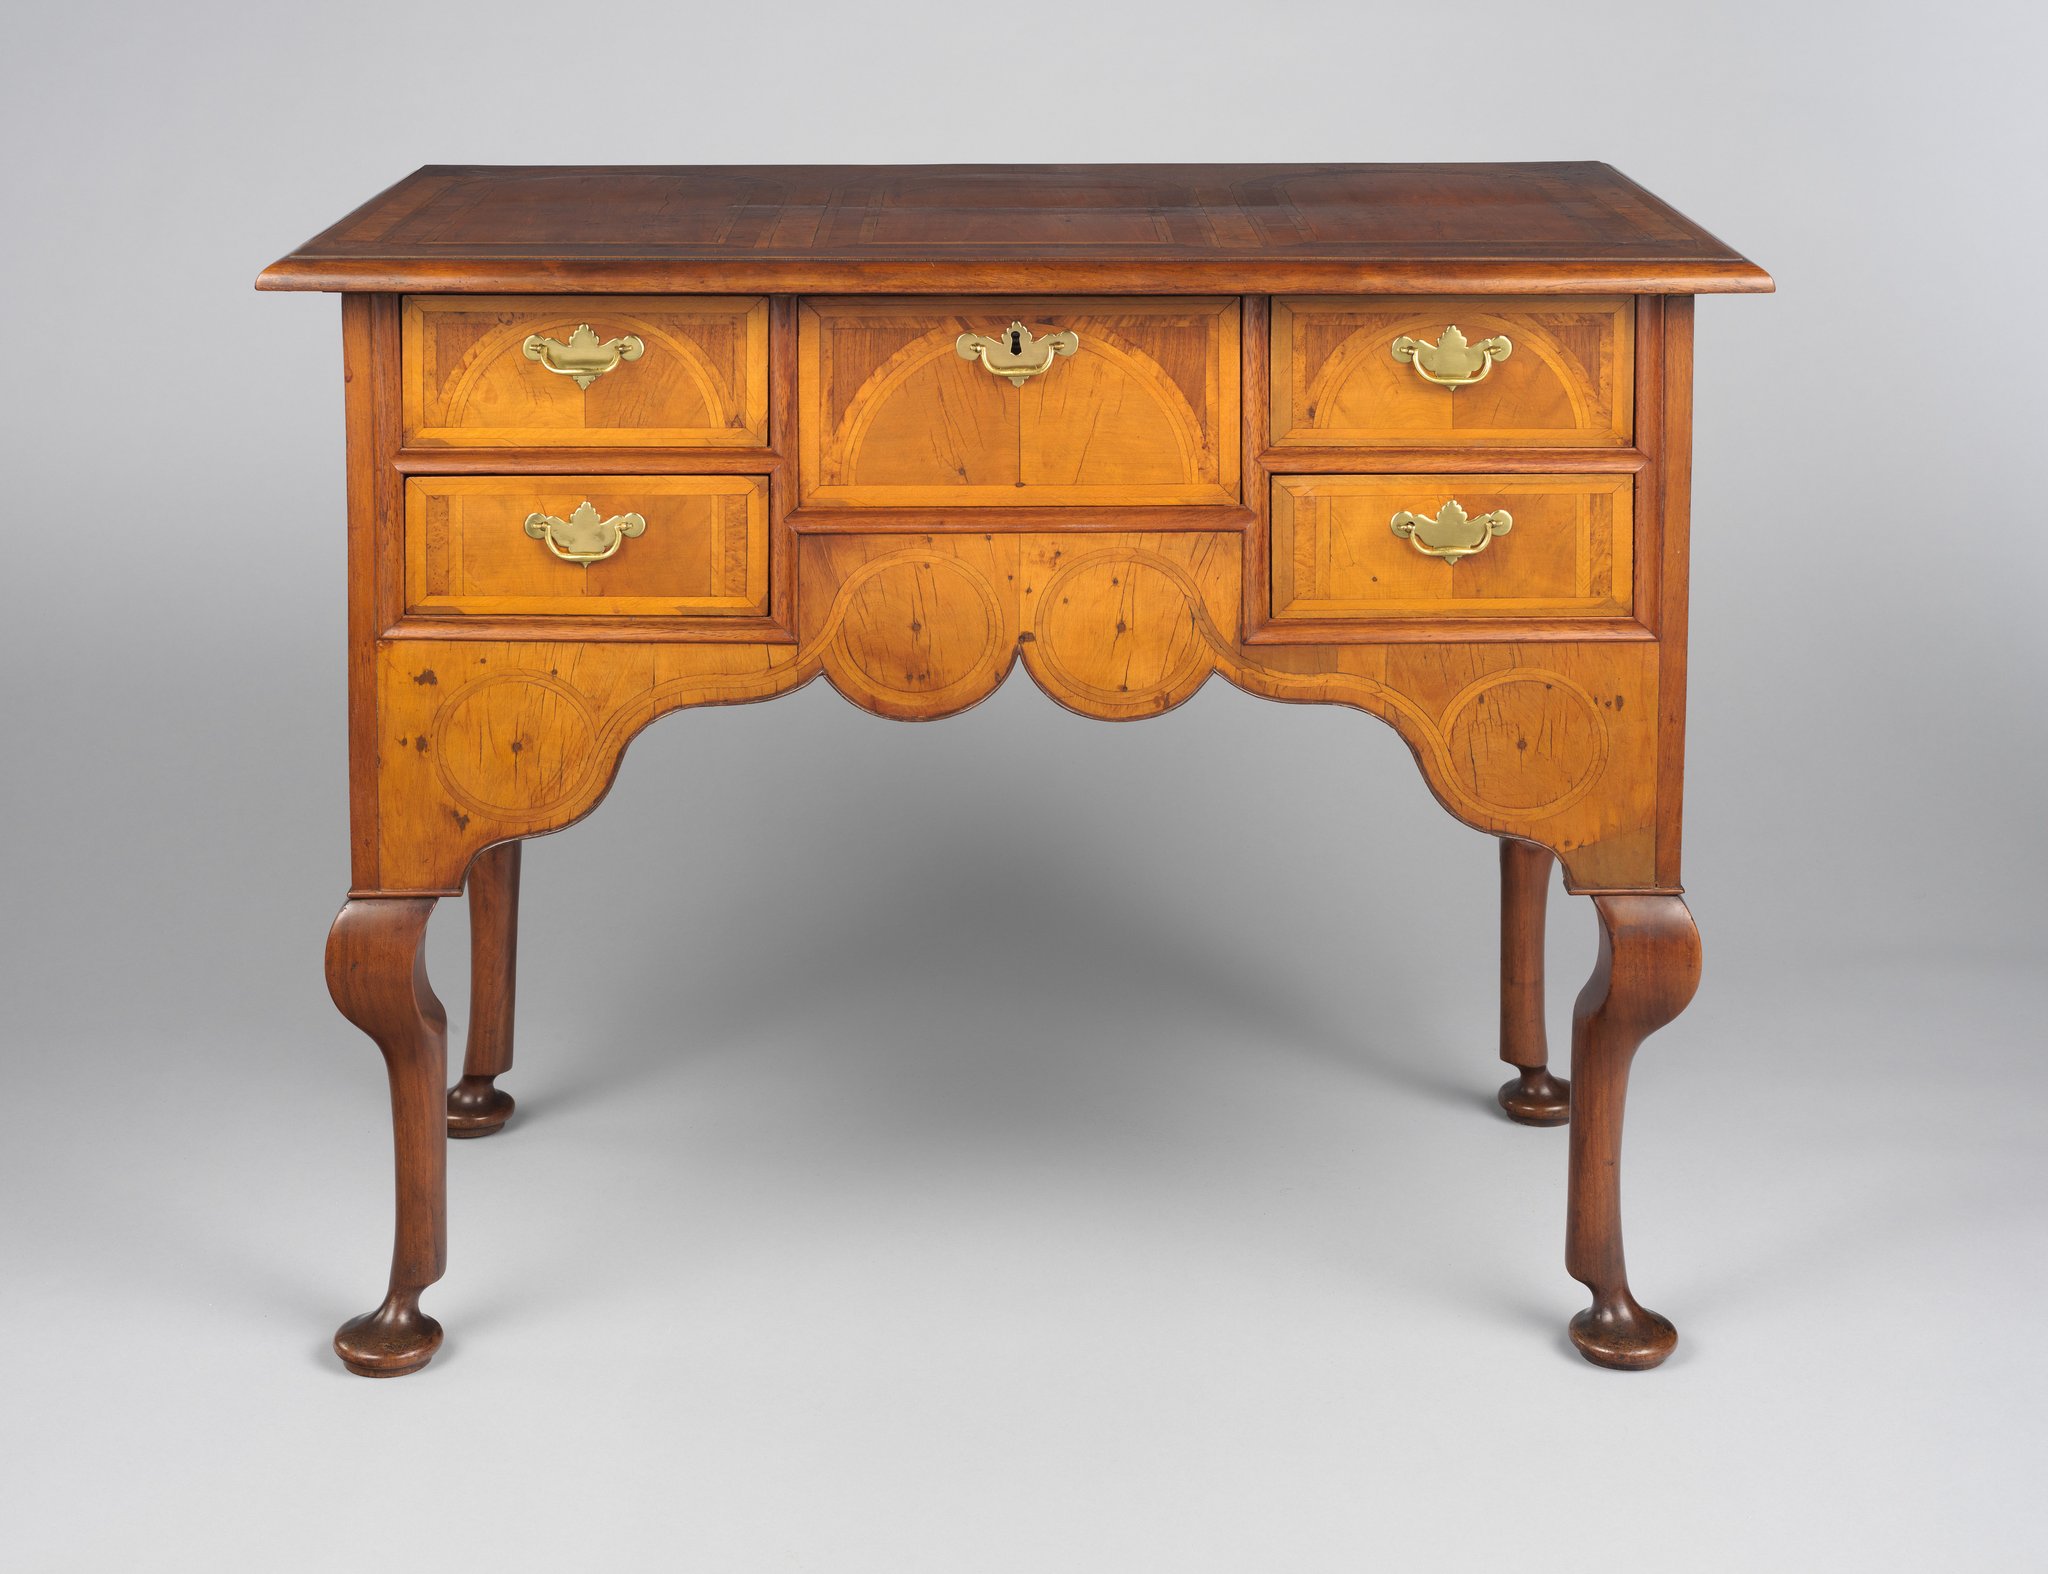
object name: dressing table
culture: american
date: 1730-1750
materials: brass, wood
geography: united states